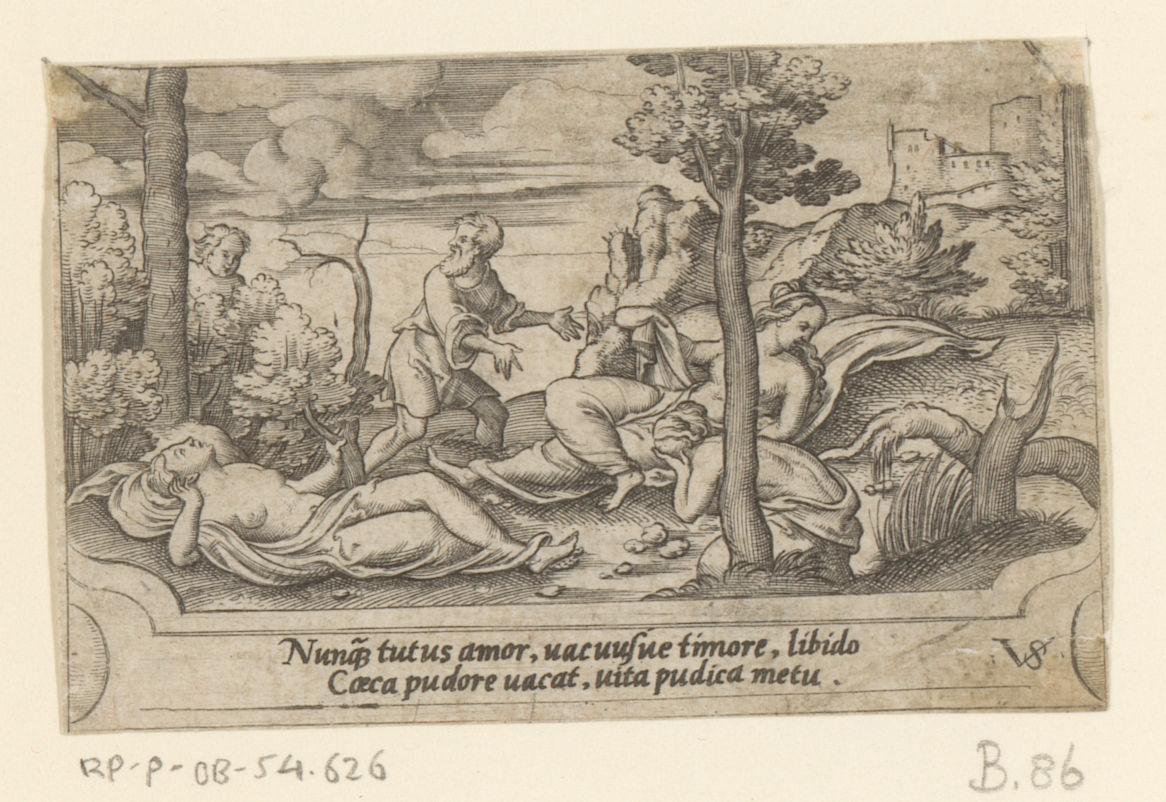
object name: print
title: Mythologische scènes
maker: virgilius solis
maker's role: draughtsman, print maker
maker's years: 1514-1562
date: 1524-1562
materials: paper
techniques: engraving, etching, intaglio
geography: nuremberg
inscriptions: number: ‘71’, collector's mark: Lugt 2228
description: Deze prent maakt deel uit van een serie van ten minste vier prenten met mythologische scènes.